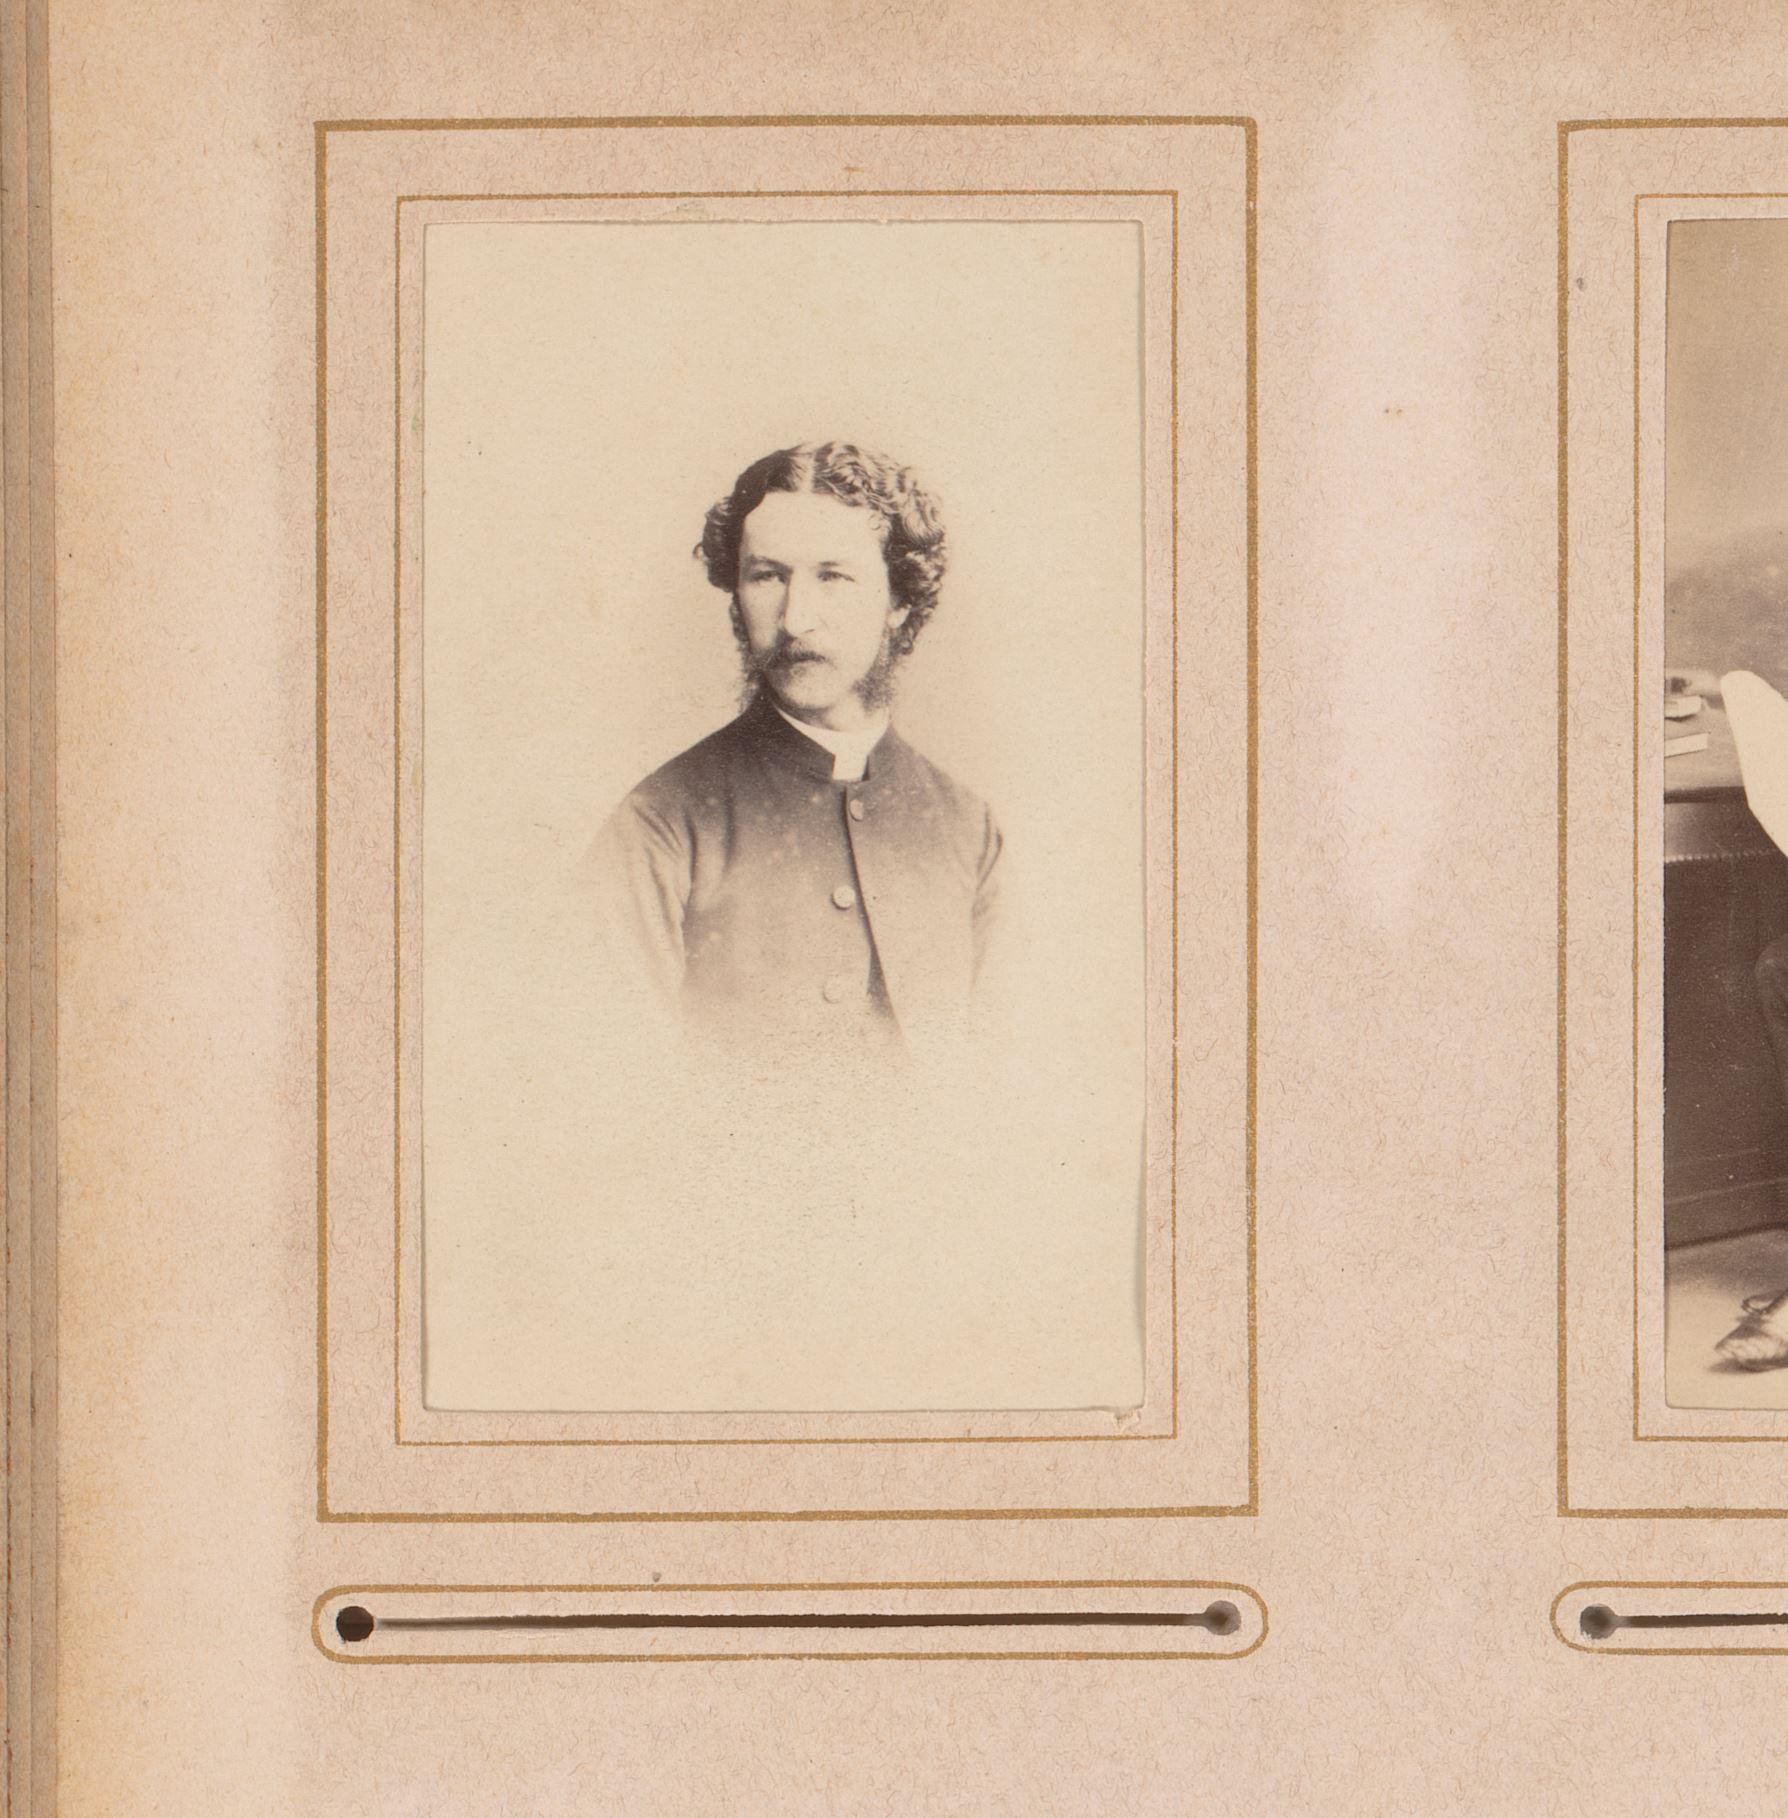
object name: photograph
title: Portret van een man met bakkebaarden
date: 1860-1890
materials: cardboard, photographic support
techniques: albumen print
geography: york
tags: sideburns, historical persons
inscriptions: inscription: ‘W.T. & R. Gowland/ Lendal/ opposite the Judges Lodgings/ York’, annotation: ‘[Ed Manti Cole]’